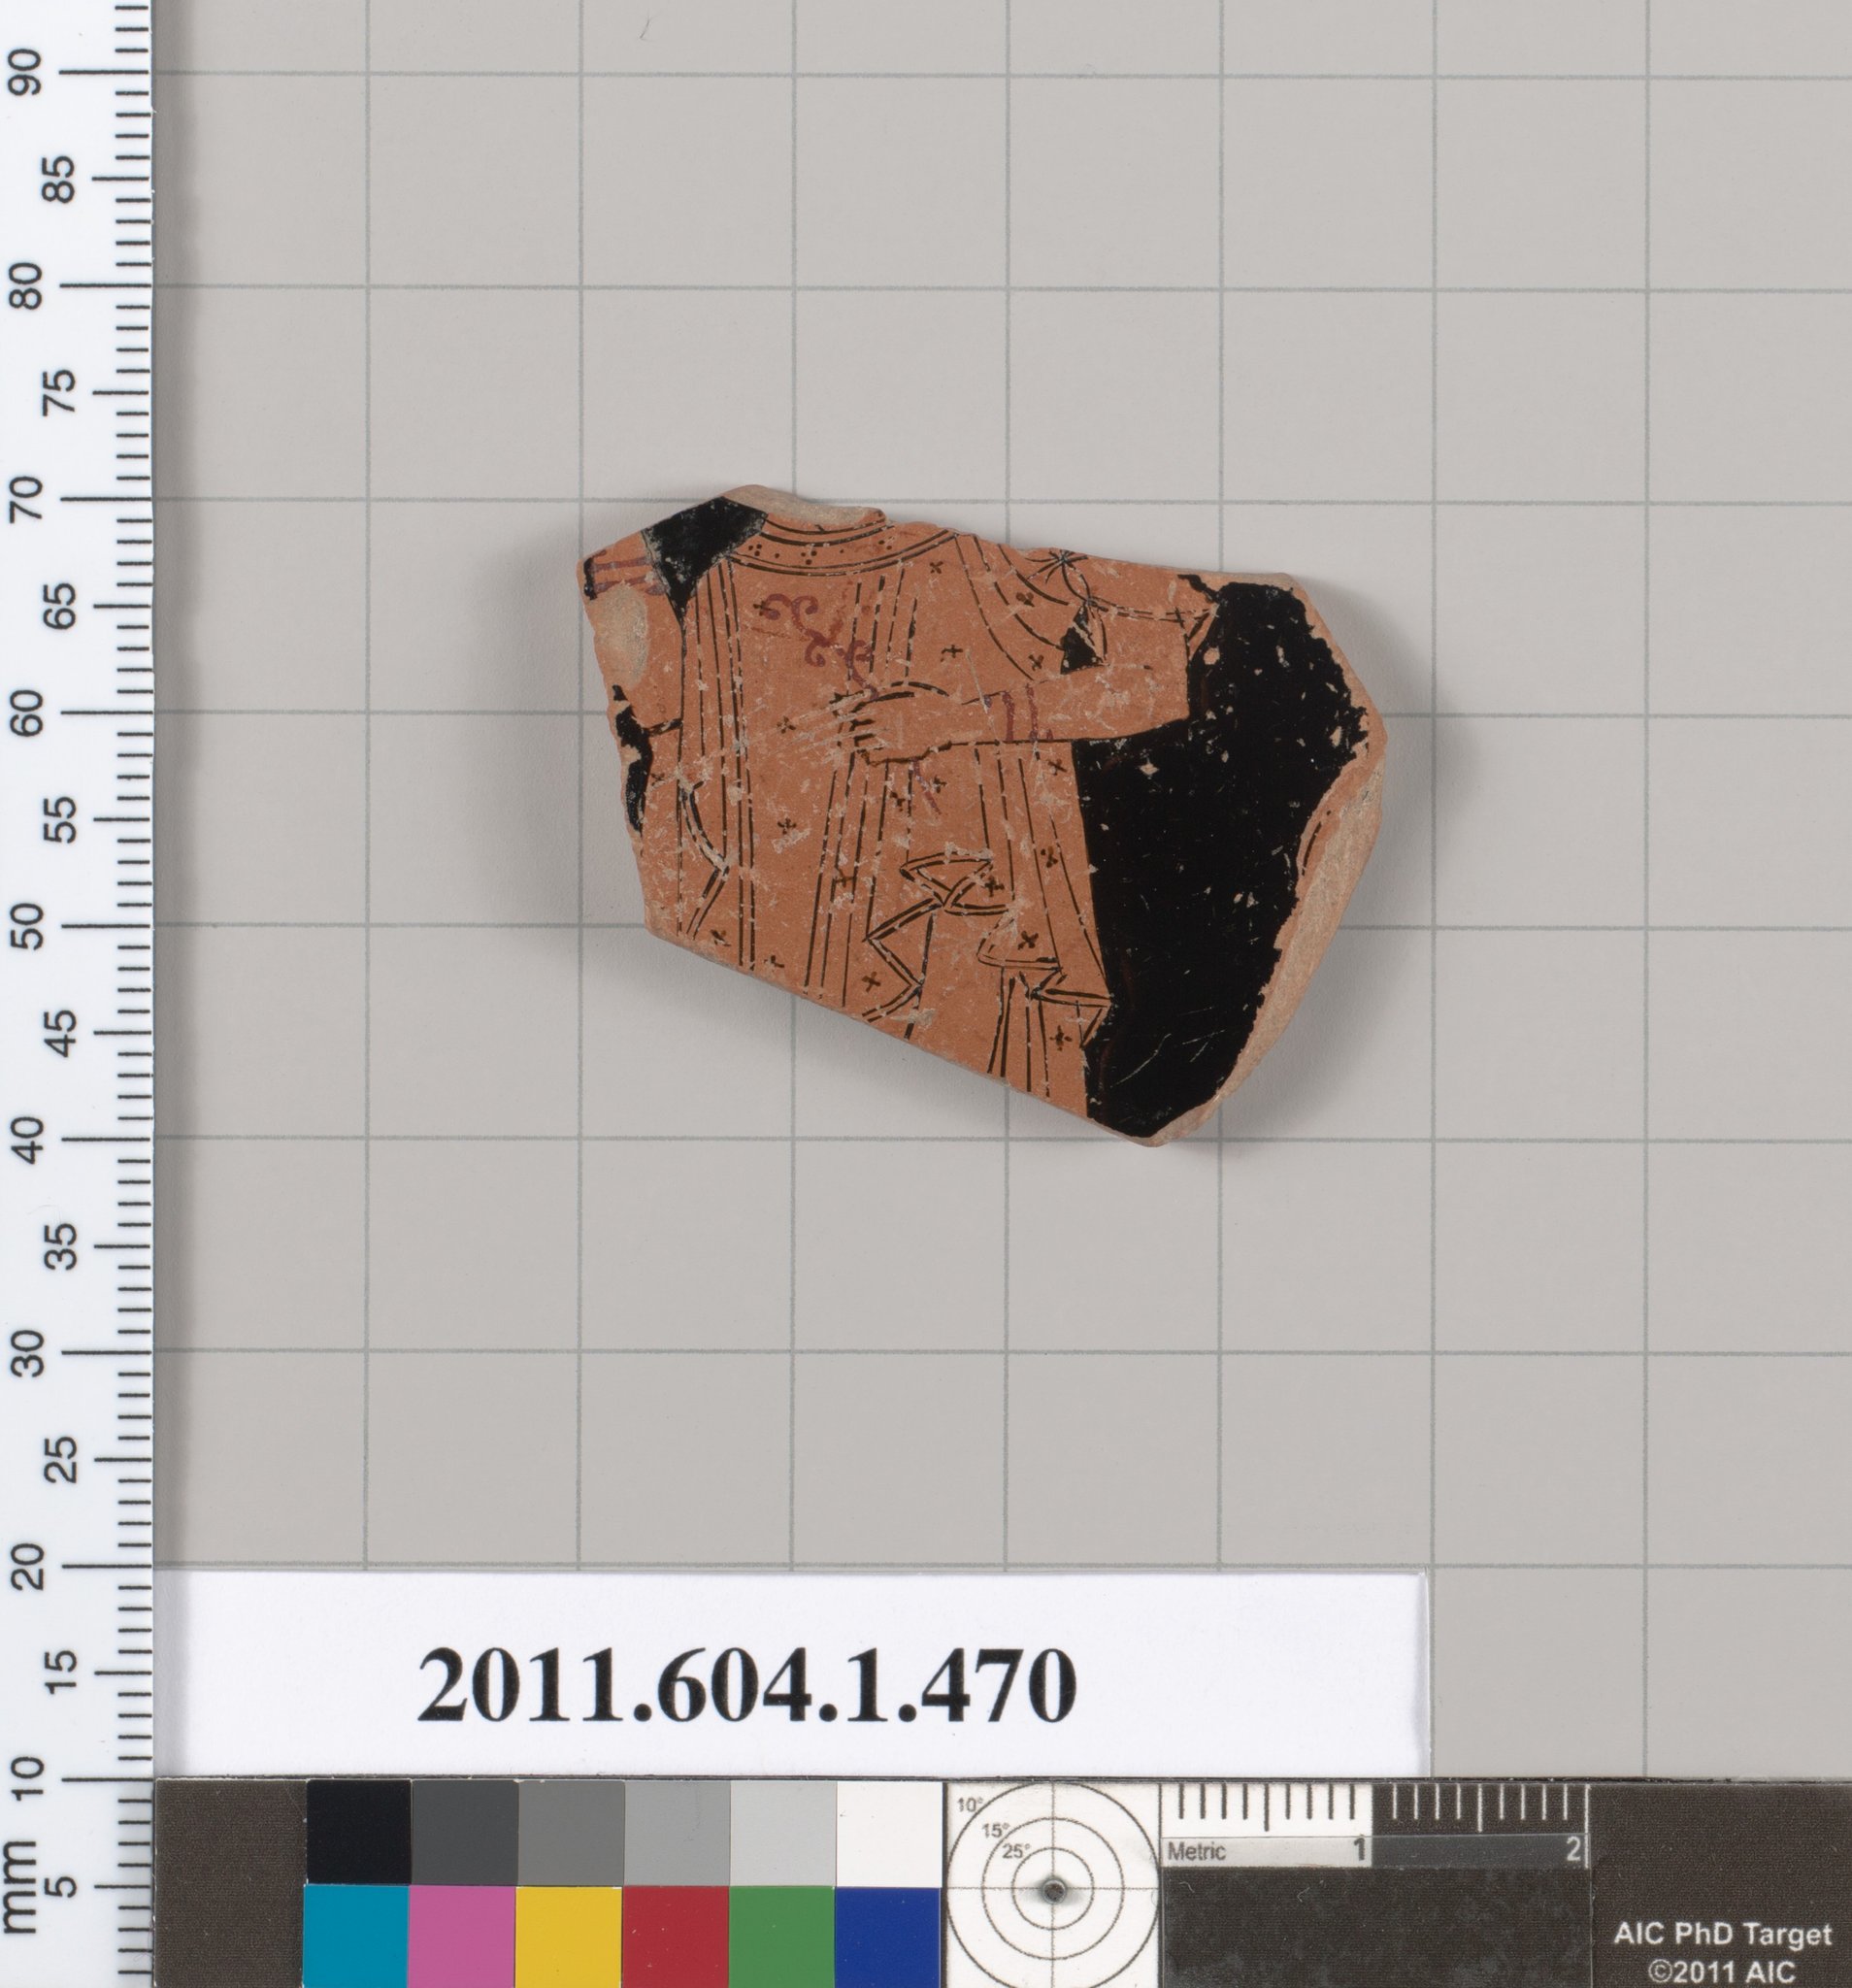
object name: kylix fragment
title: Terracotta fragment of a kylix (drinking cup)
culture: greek, attic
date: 534-501 BCE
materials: terracotta